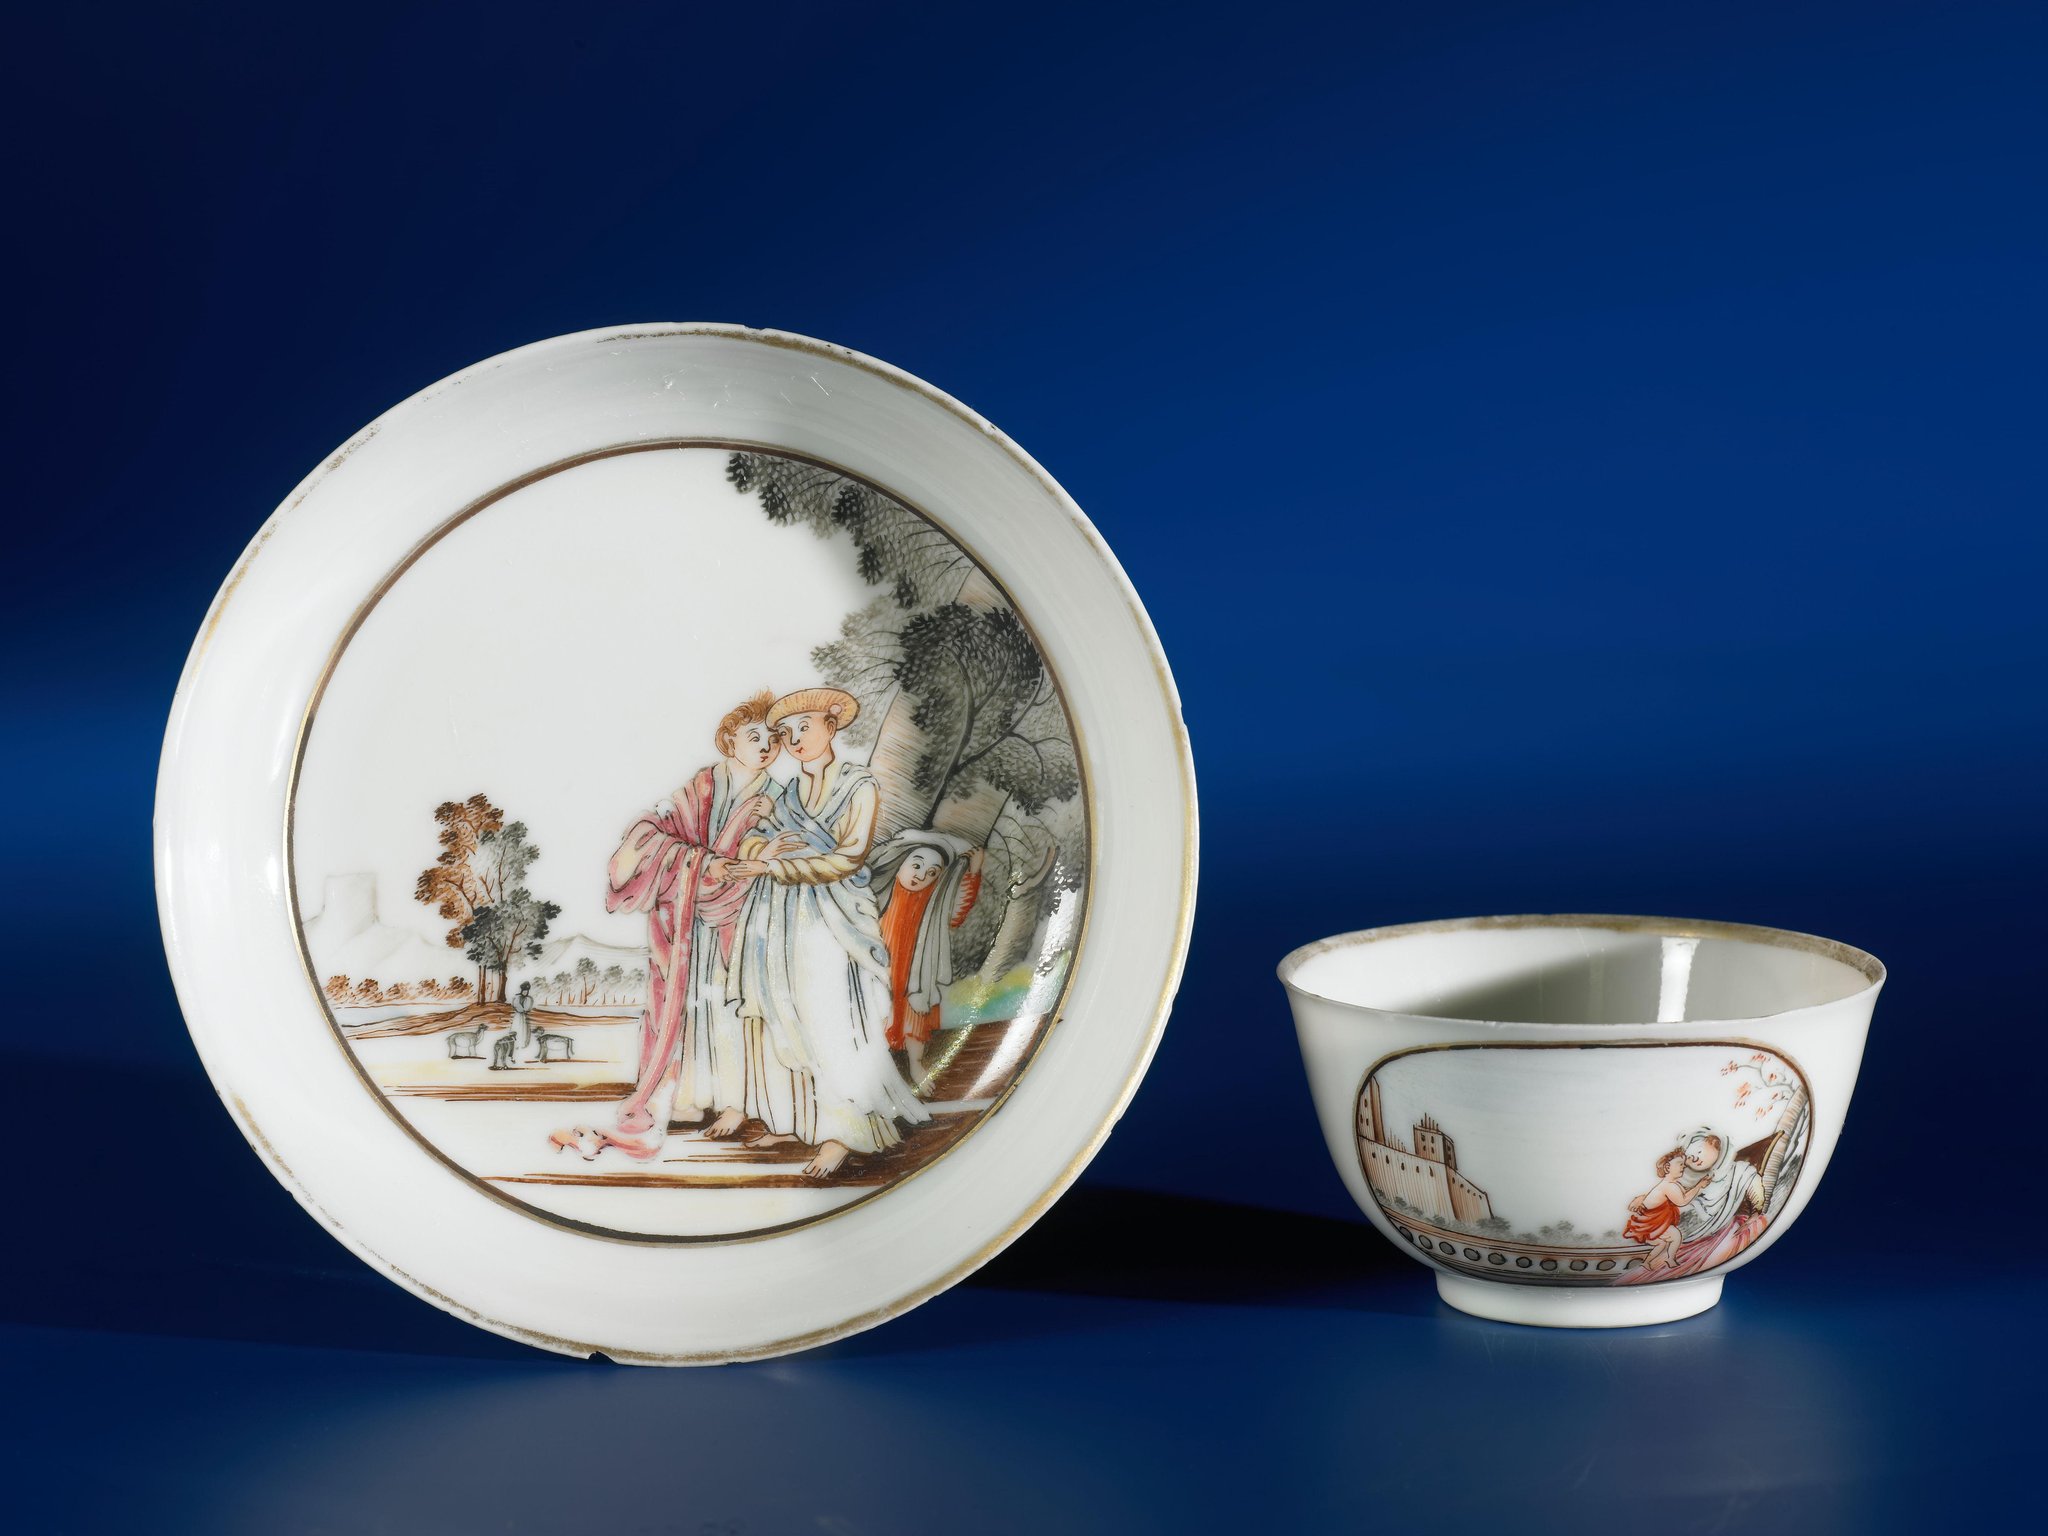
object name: platter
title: Saucer with European figures in a landscape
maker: Anonymous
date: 1740-1760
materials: glaze, gold, paint, porcelain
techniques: firing, gilding, turning, vitrification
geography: china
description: Wijd uitlopende kop op een hoge voetring en schotel op een voetring. Gedecoreerd in emailkleuren en goud. Op het bord een voorstelling van een verliefd paar in een landschap, gadegeslagen door een derde figuurtje. Op de achtergrond drie schapen en een herder. Op het kopje een voorstelling van een vrouw, zij houdt een kind vast. Op de achtergrond een kasteel.